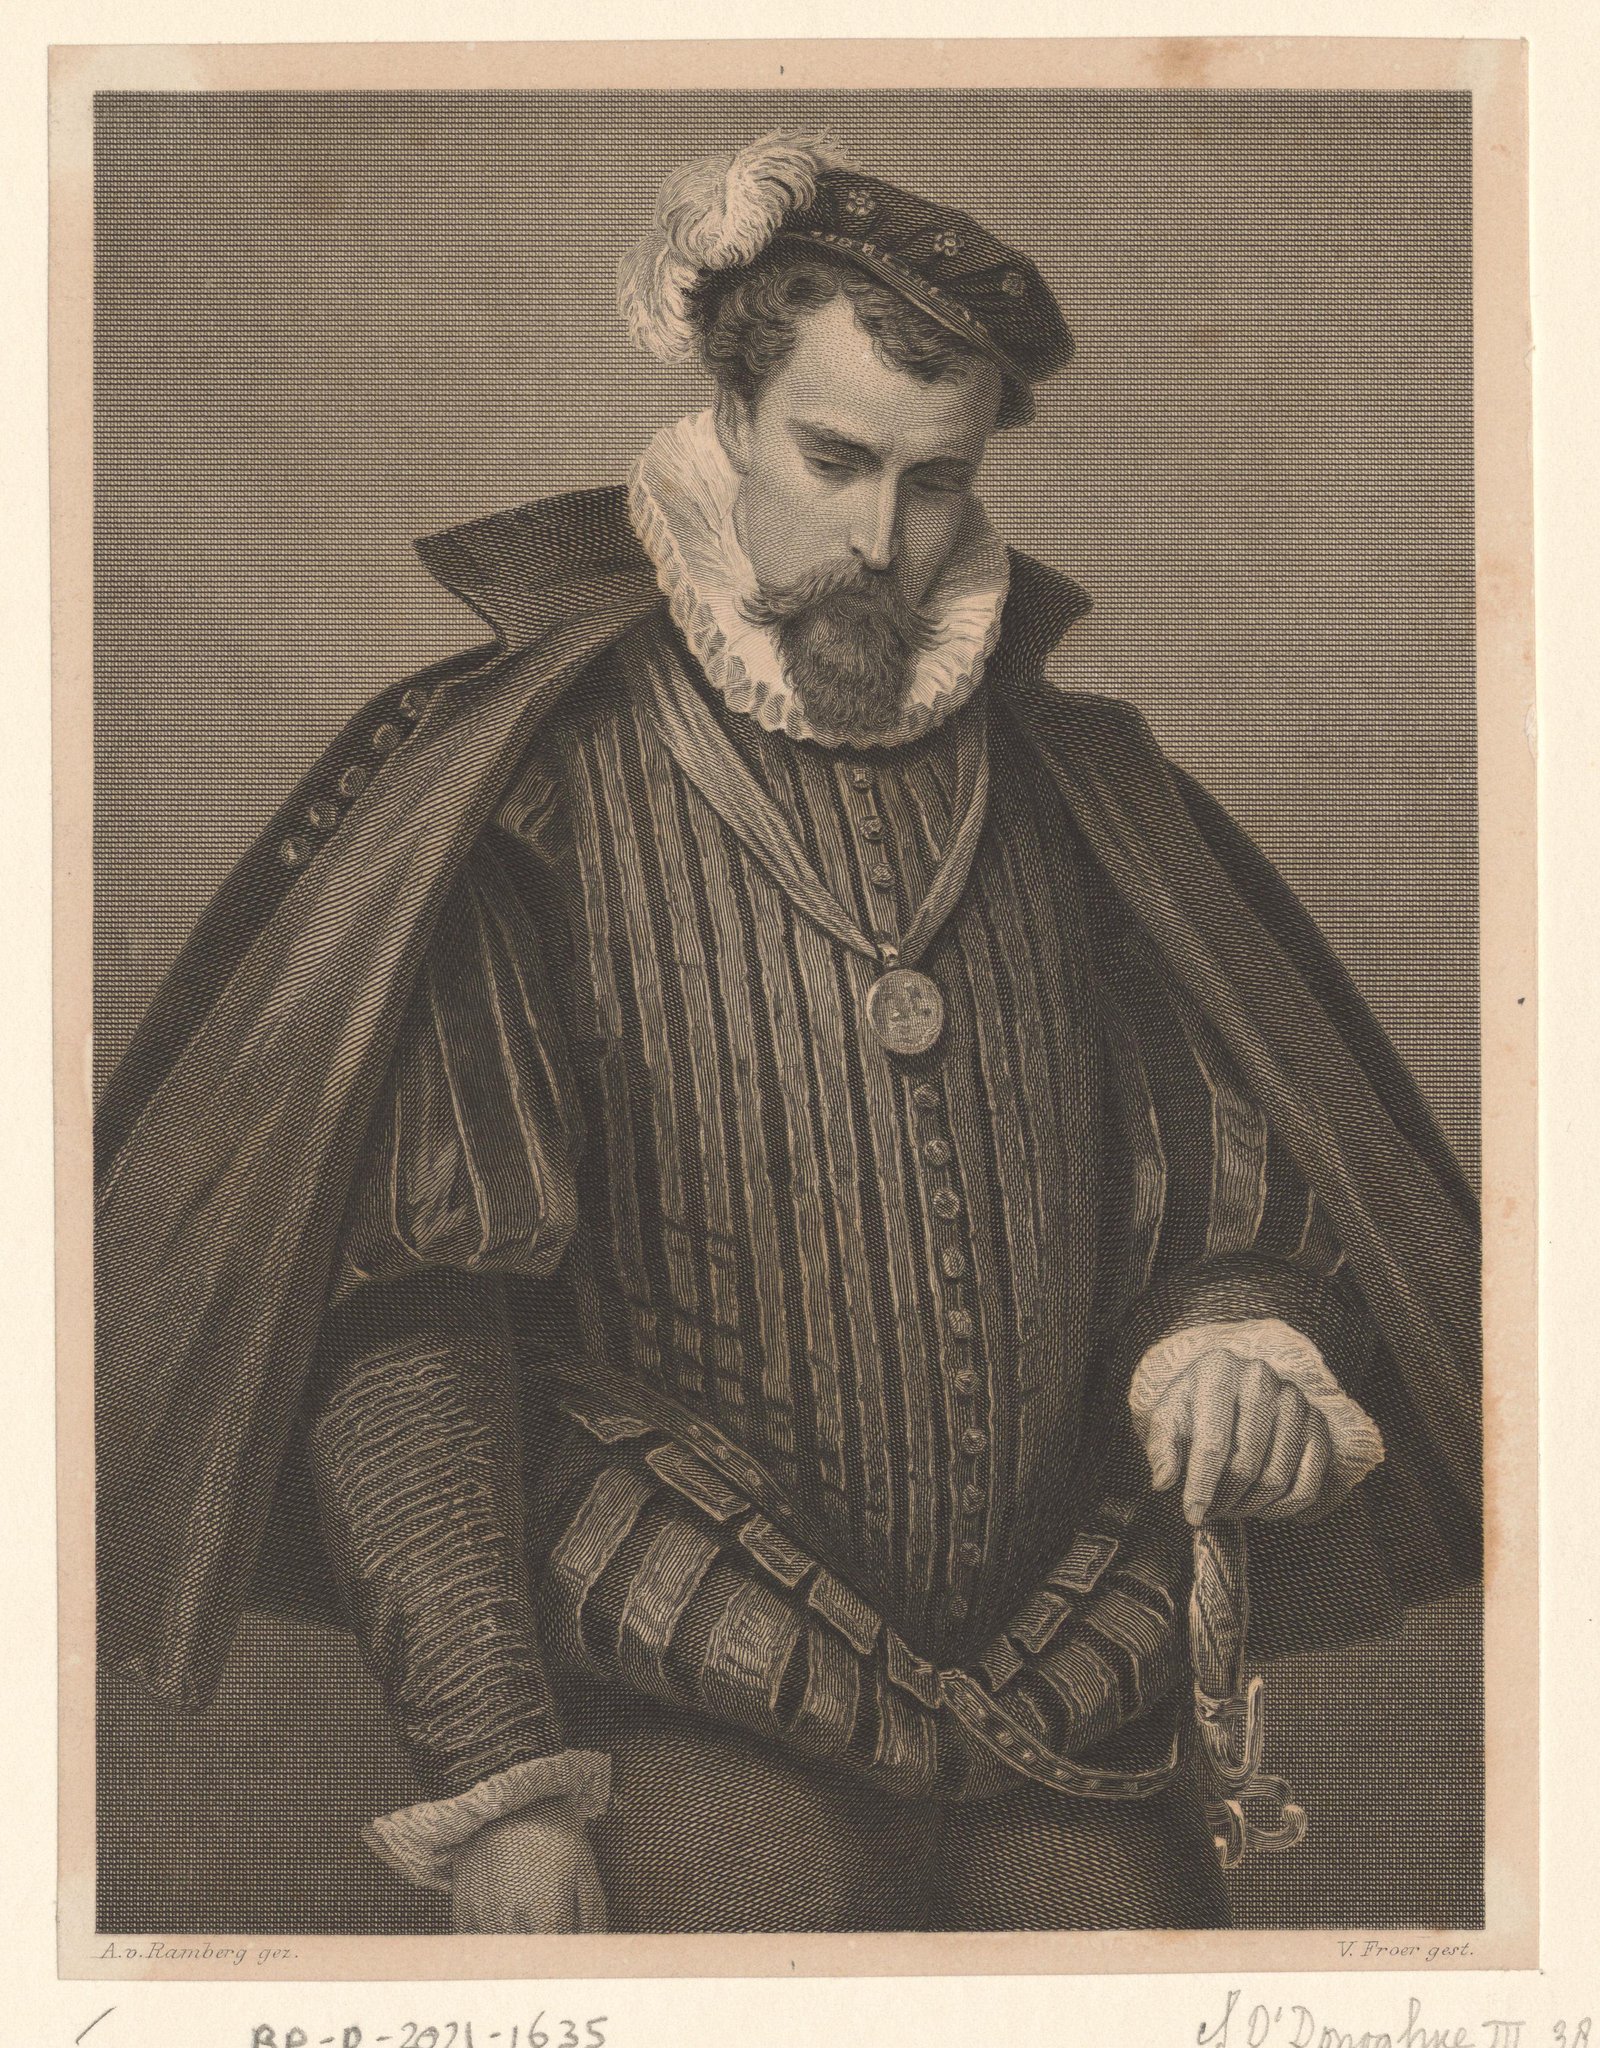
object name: print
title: Portret van Robert Dudley, graaf van Leicester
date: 1859-1900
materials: paper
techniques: engraving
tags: robert dudley (1st earl of leicester), historical persons, hacking and thrusting weapons: sword